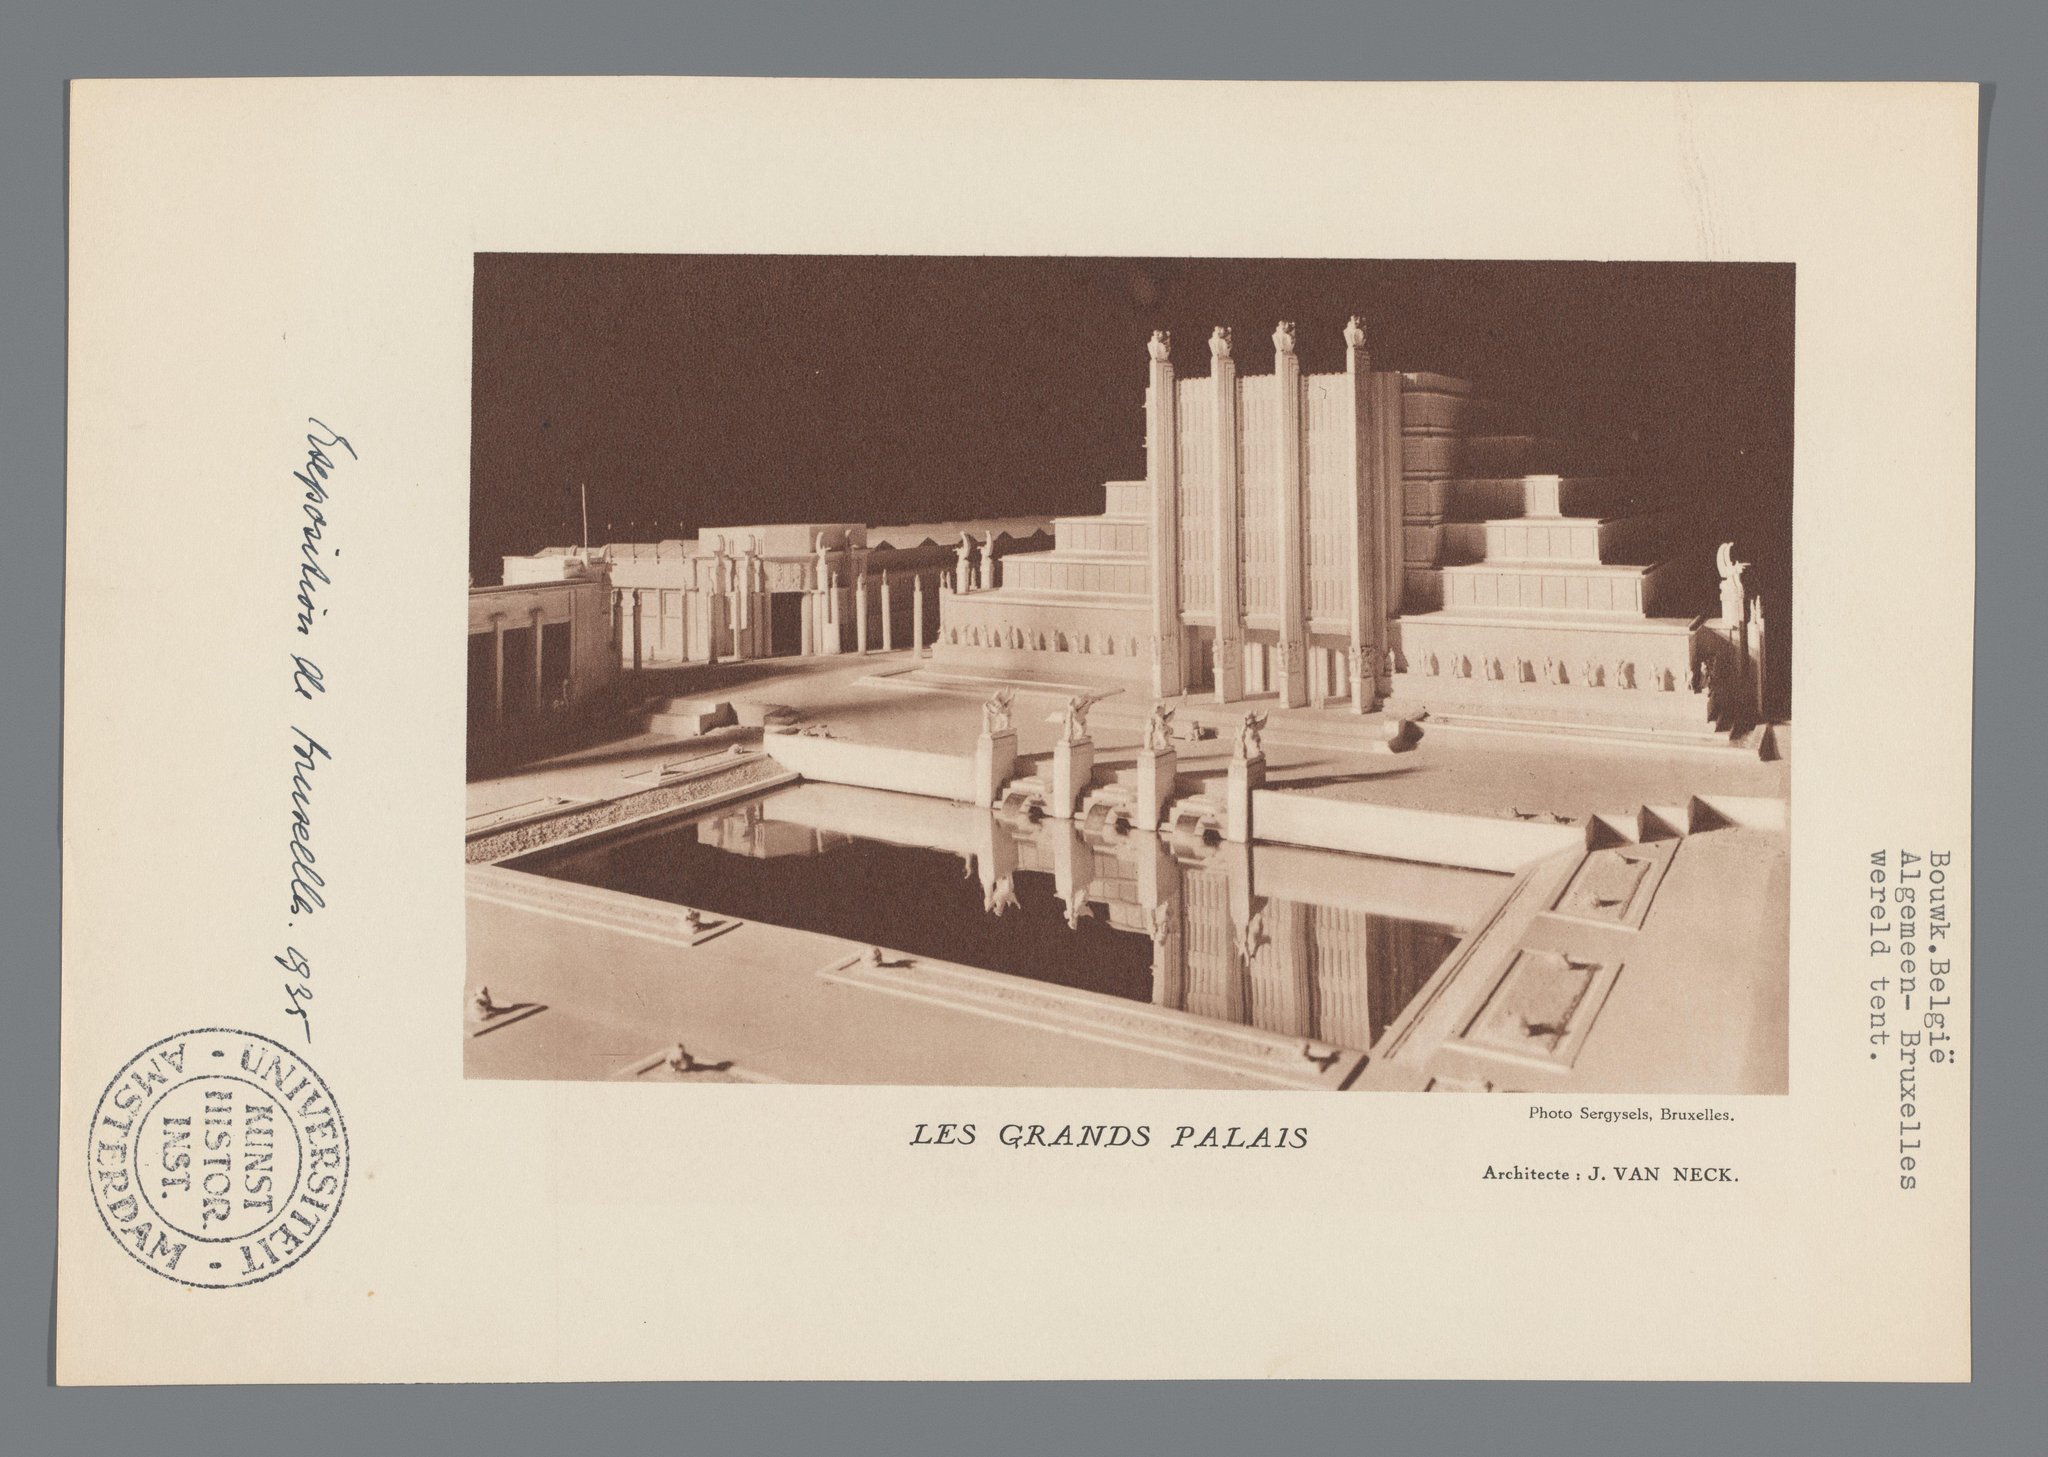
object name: photograph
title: Brussels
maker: Anonymous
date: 1935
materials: photographic support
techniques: rotogravure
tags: brussels